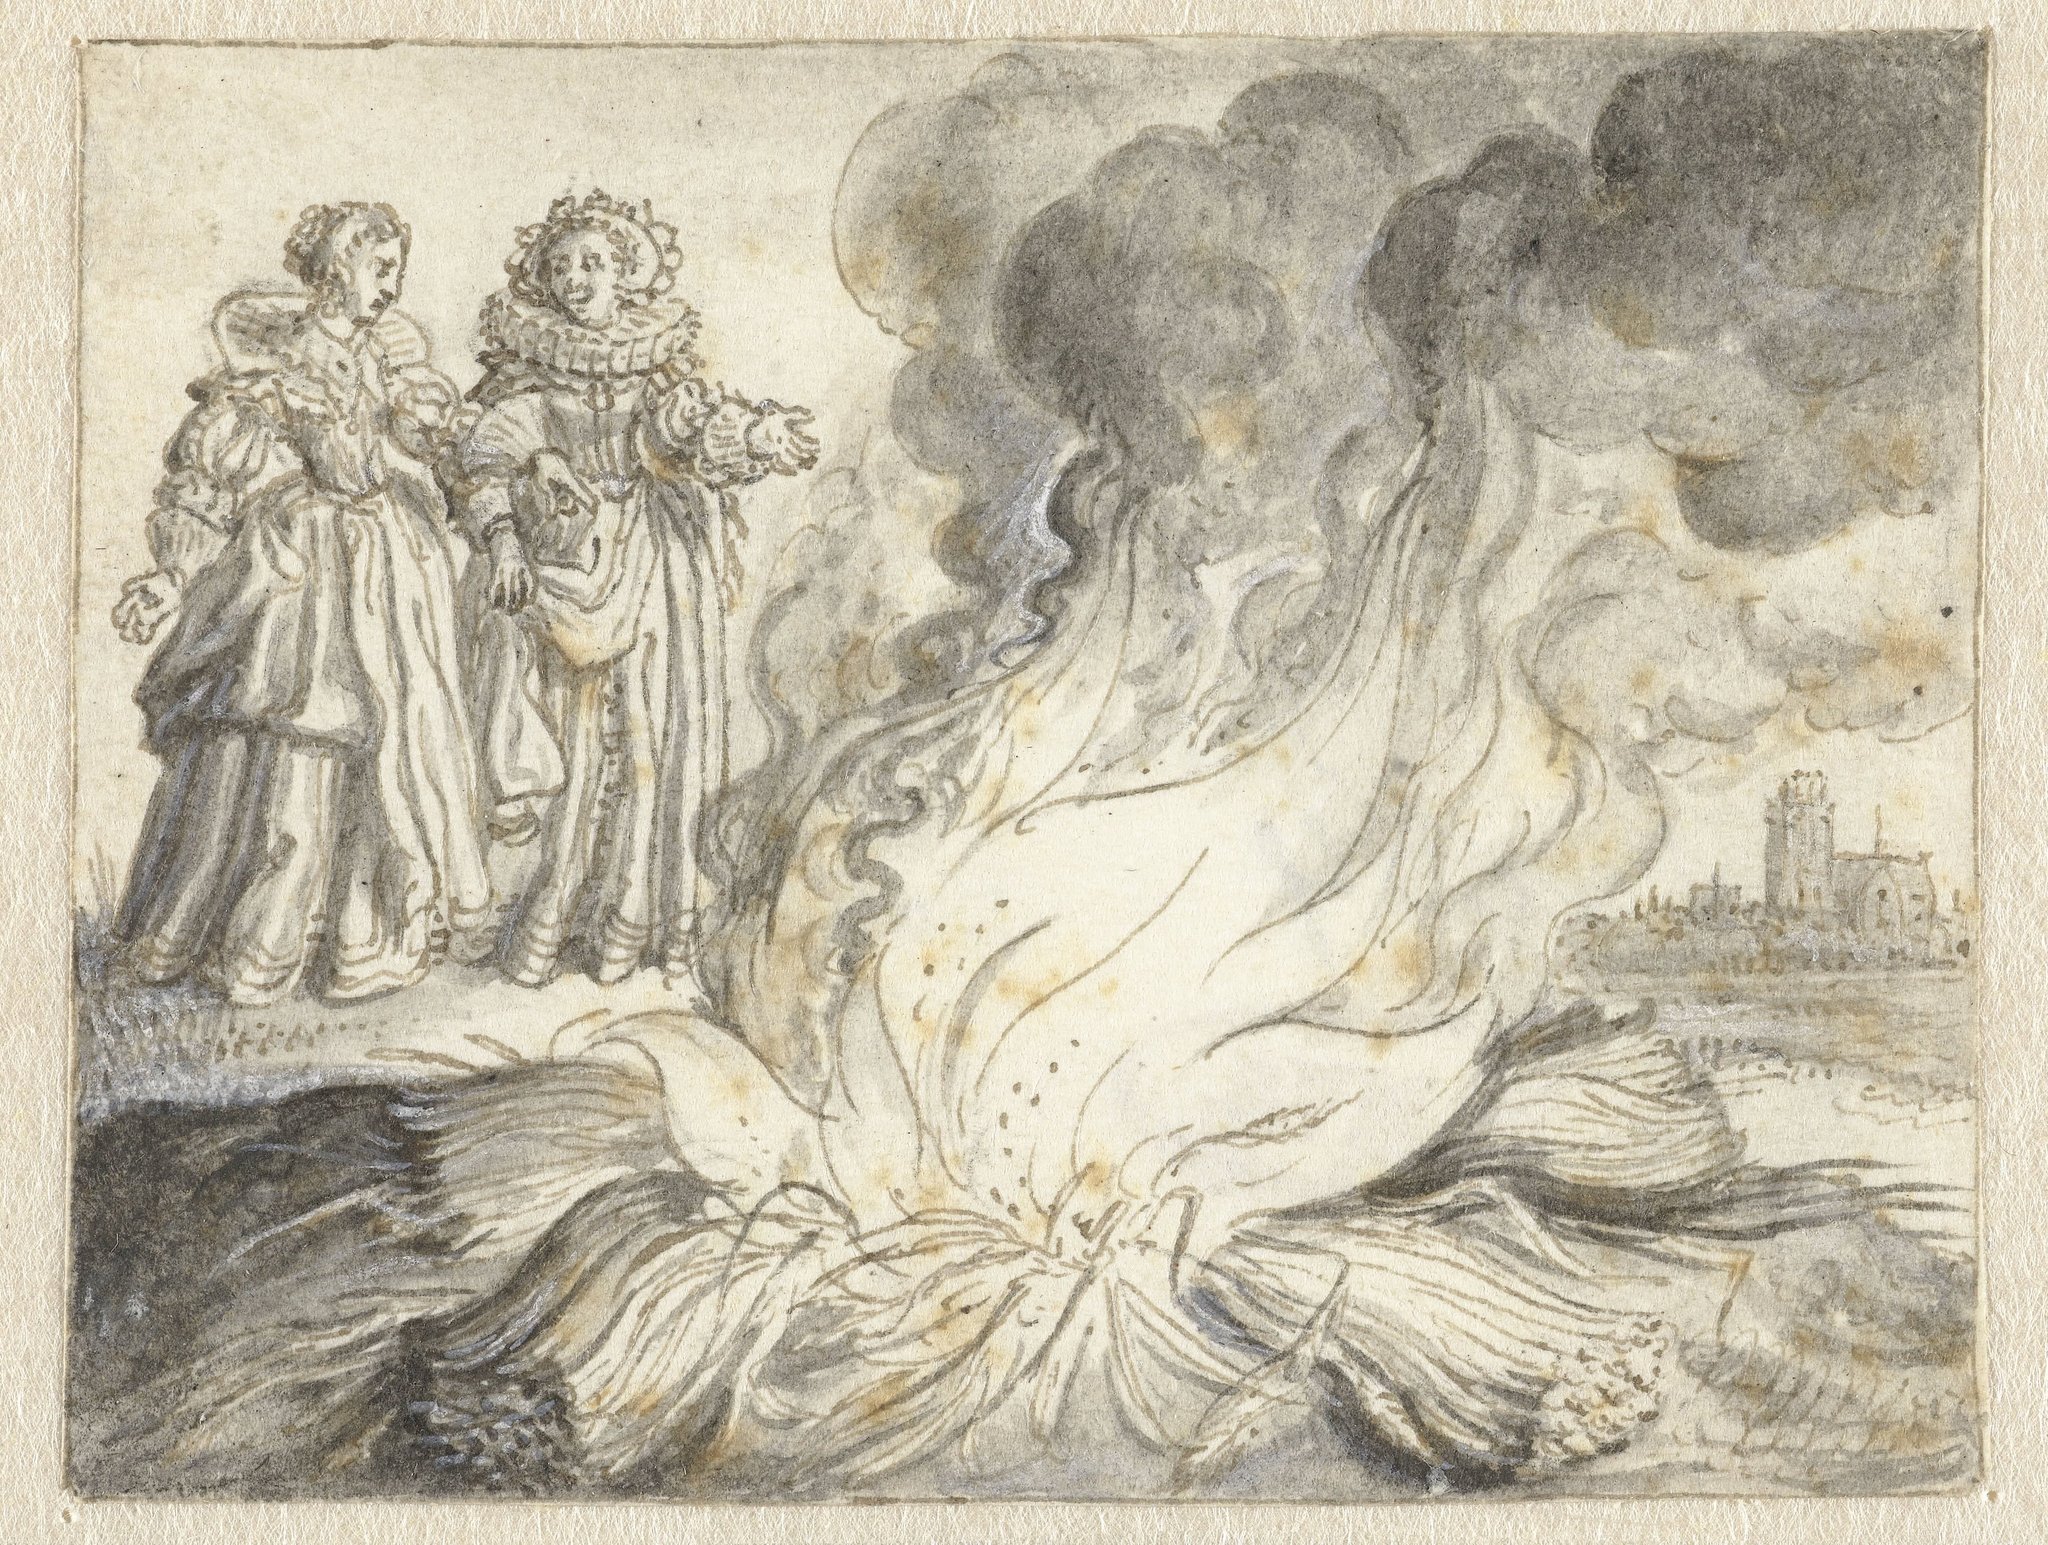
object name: drawing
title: ‘Passion is the Fire of Naught but Straw’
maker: adriaen pietersz van de venne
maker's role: draughtsman, painter, print maker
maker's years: 1589-1662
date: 1628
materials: paint, ink, paper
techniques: brush, pen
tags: (scenes from) specific works of literature (with author, title), burning as process, female literary characters (with name), hay-cock, reason versus amorous lust; 'combattimento della ragione con l'appetito' (ripa) (+ situation or event (especially in genre-painting) with symbolical connotation)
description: Ontwerp voor een illustratie in Jacob Cats' "Hovwelyck ..." van 1628: twee vrouwen, Phyllis en Anna, bij brandend stro.